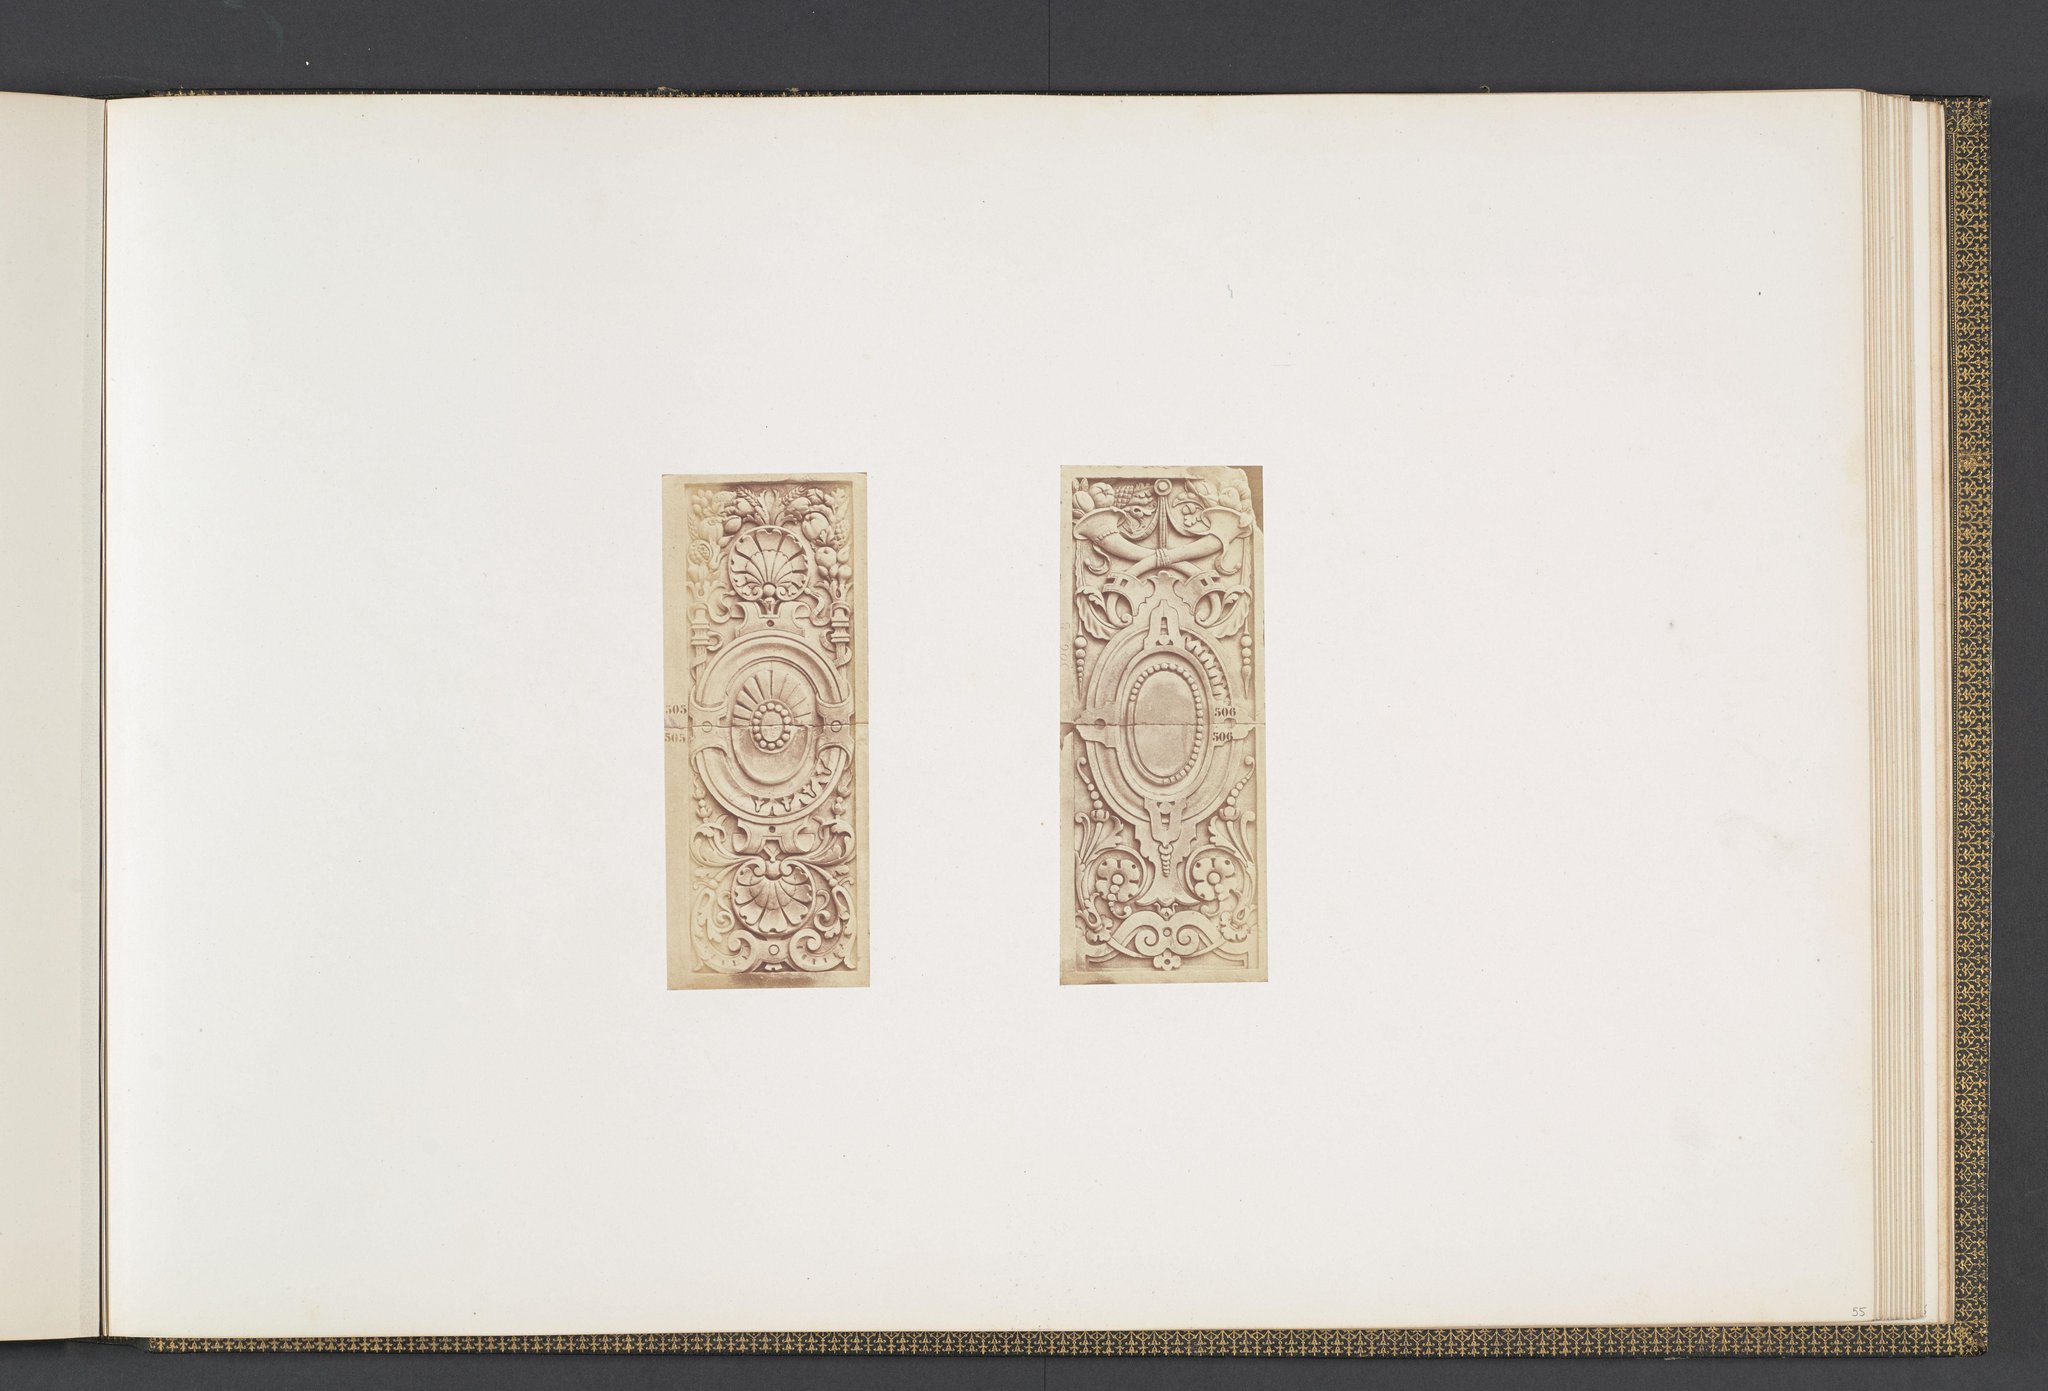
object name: album leaf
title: Gipsmodellen voor versieringen op het Palais du Louvre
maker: édouard denis baldus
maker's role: fotograaf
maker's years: 1813-1889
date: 1855-1857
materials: paper, photographic support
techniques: salted paper print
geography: paris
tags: permanent exhibition, museum, ornamenting, decorating ~ applied arts, paris, tuileries palace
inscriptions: number: ‘505 en 506’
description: Onderdeel van Réunion des Tuileries au Louvre 1852-1857, album 3.